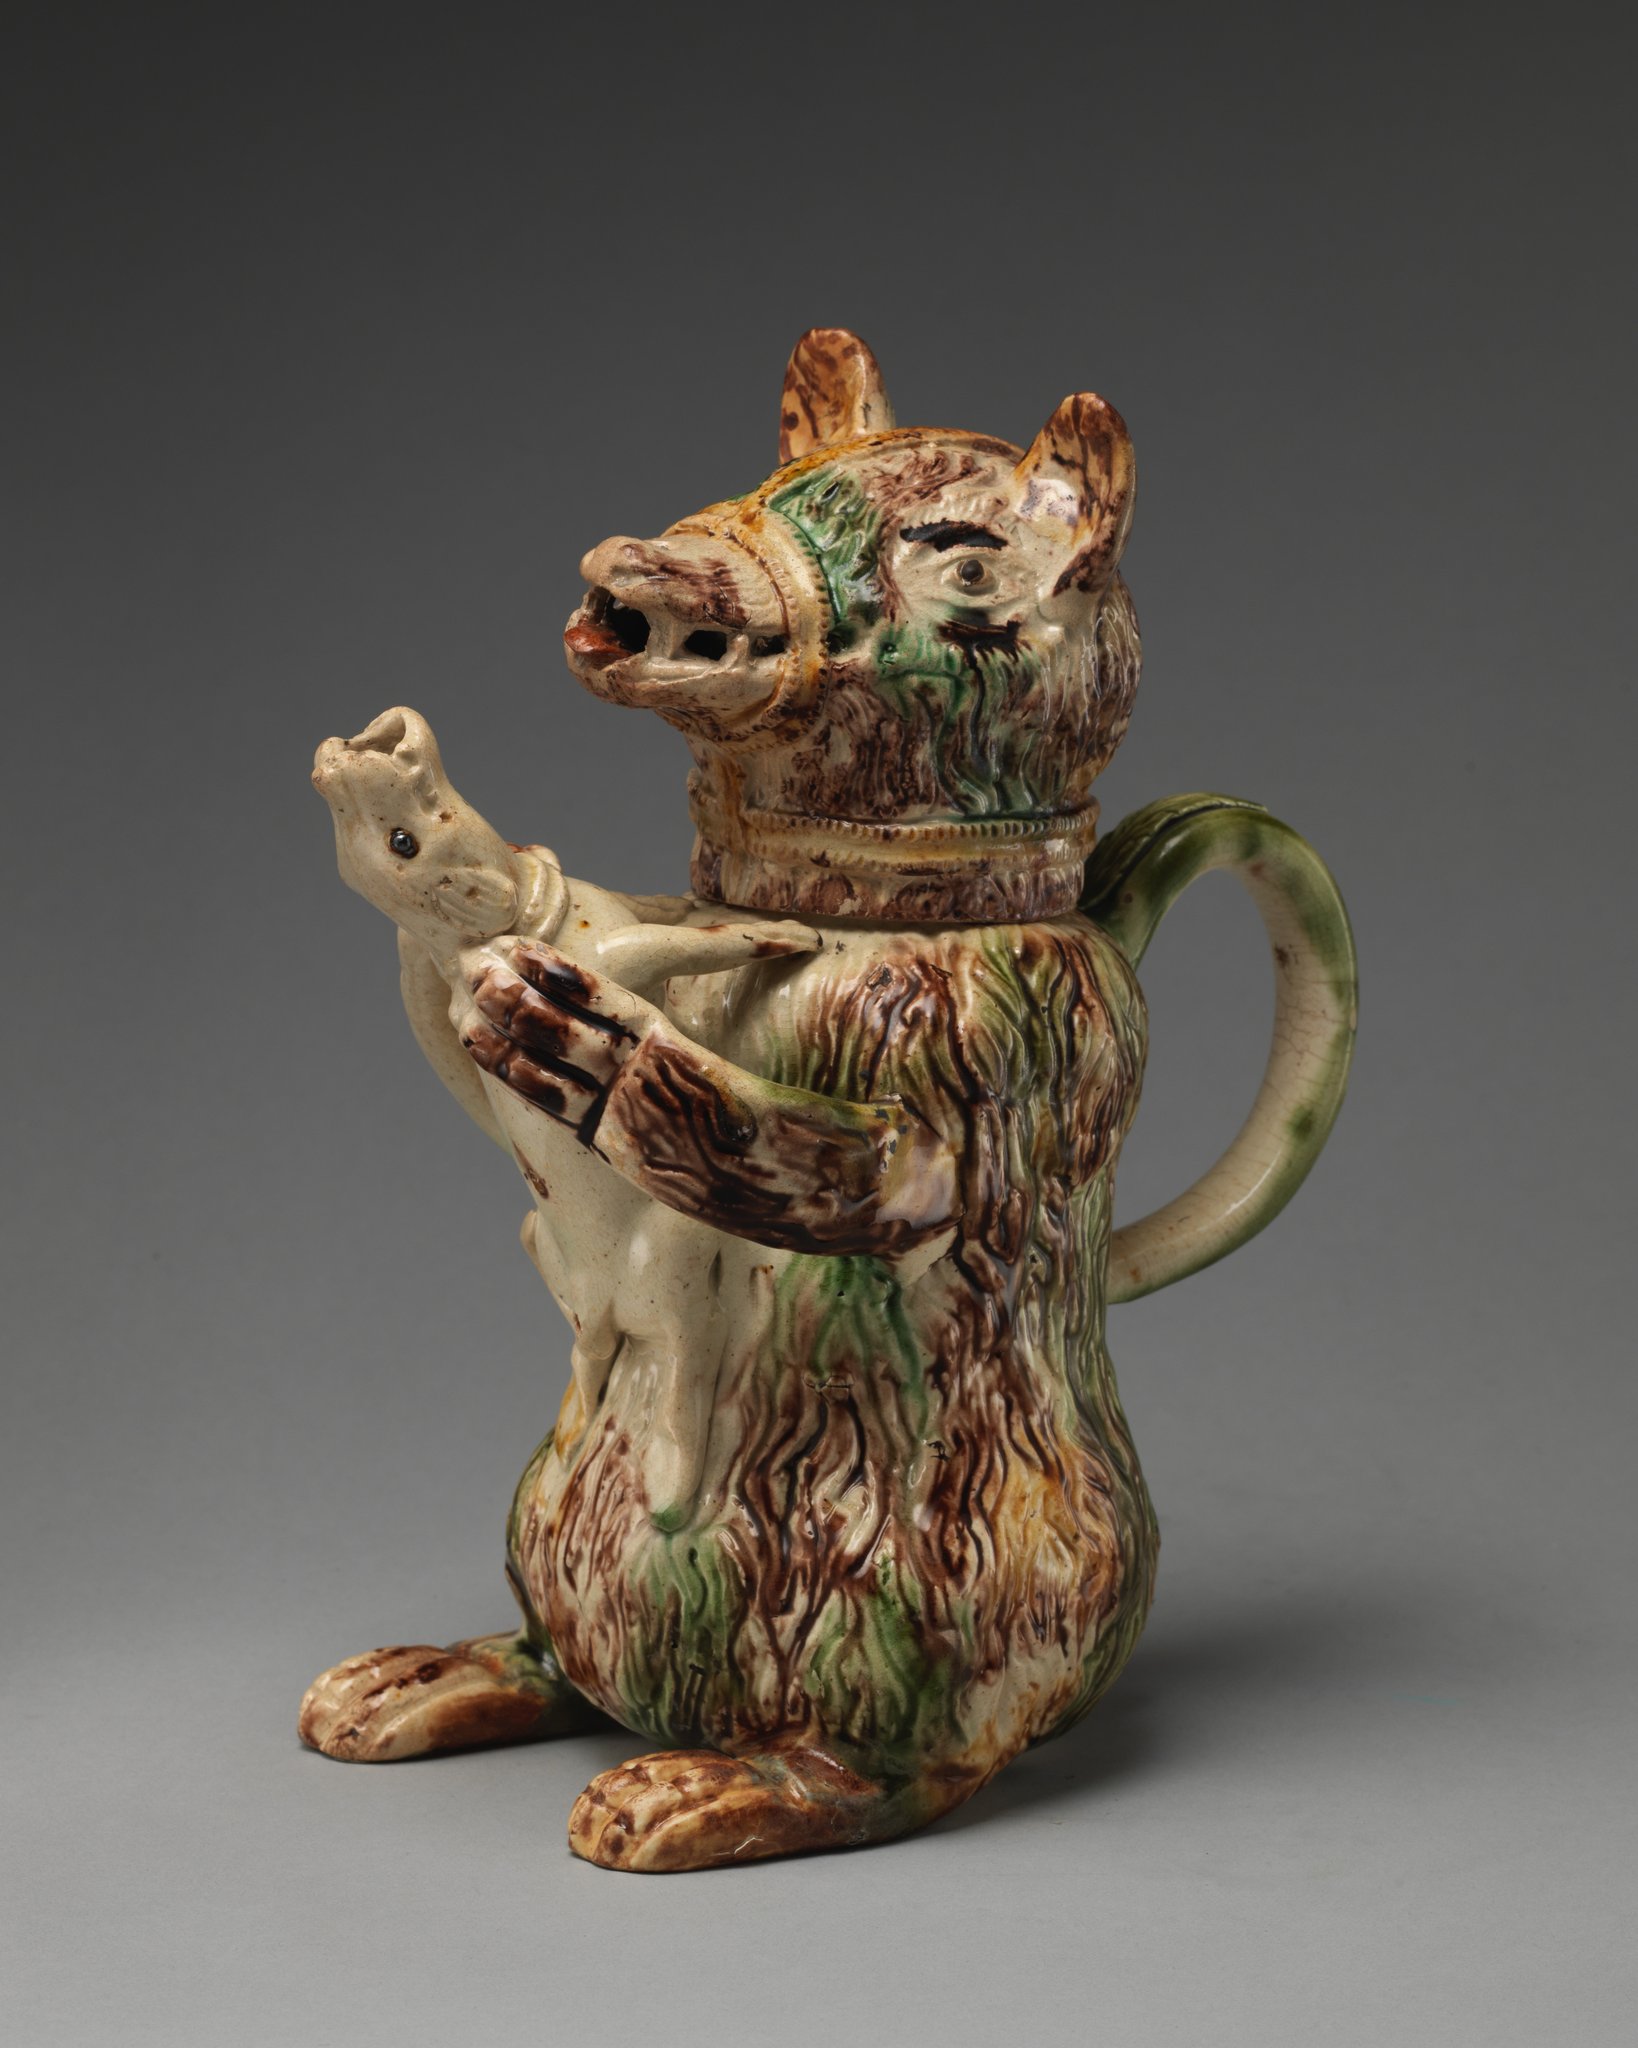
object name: jug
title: Jug in the form of a bear hugging a small dog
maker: astbury-whieldon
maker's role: maker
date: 1734-1766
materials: earthenware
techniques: glazing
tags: bears,dogs